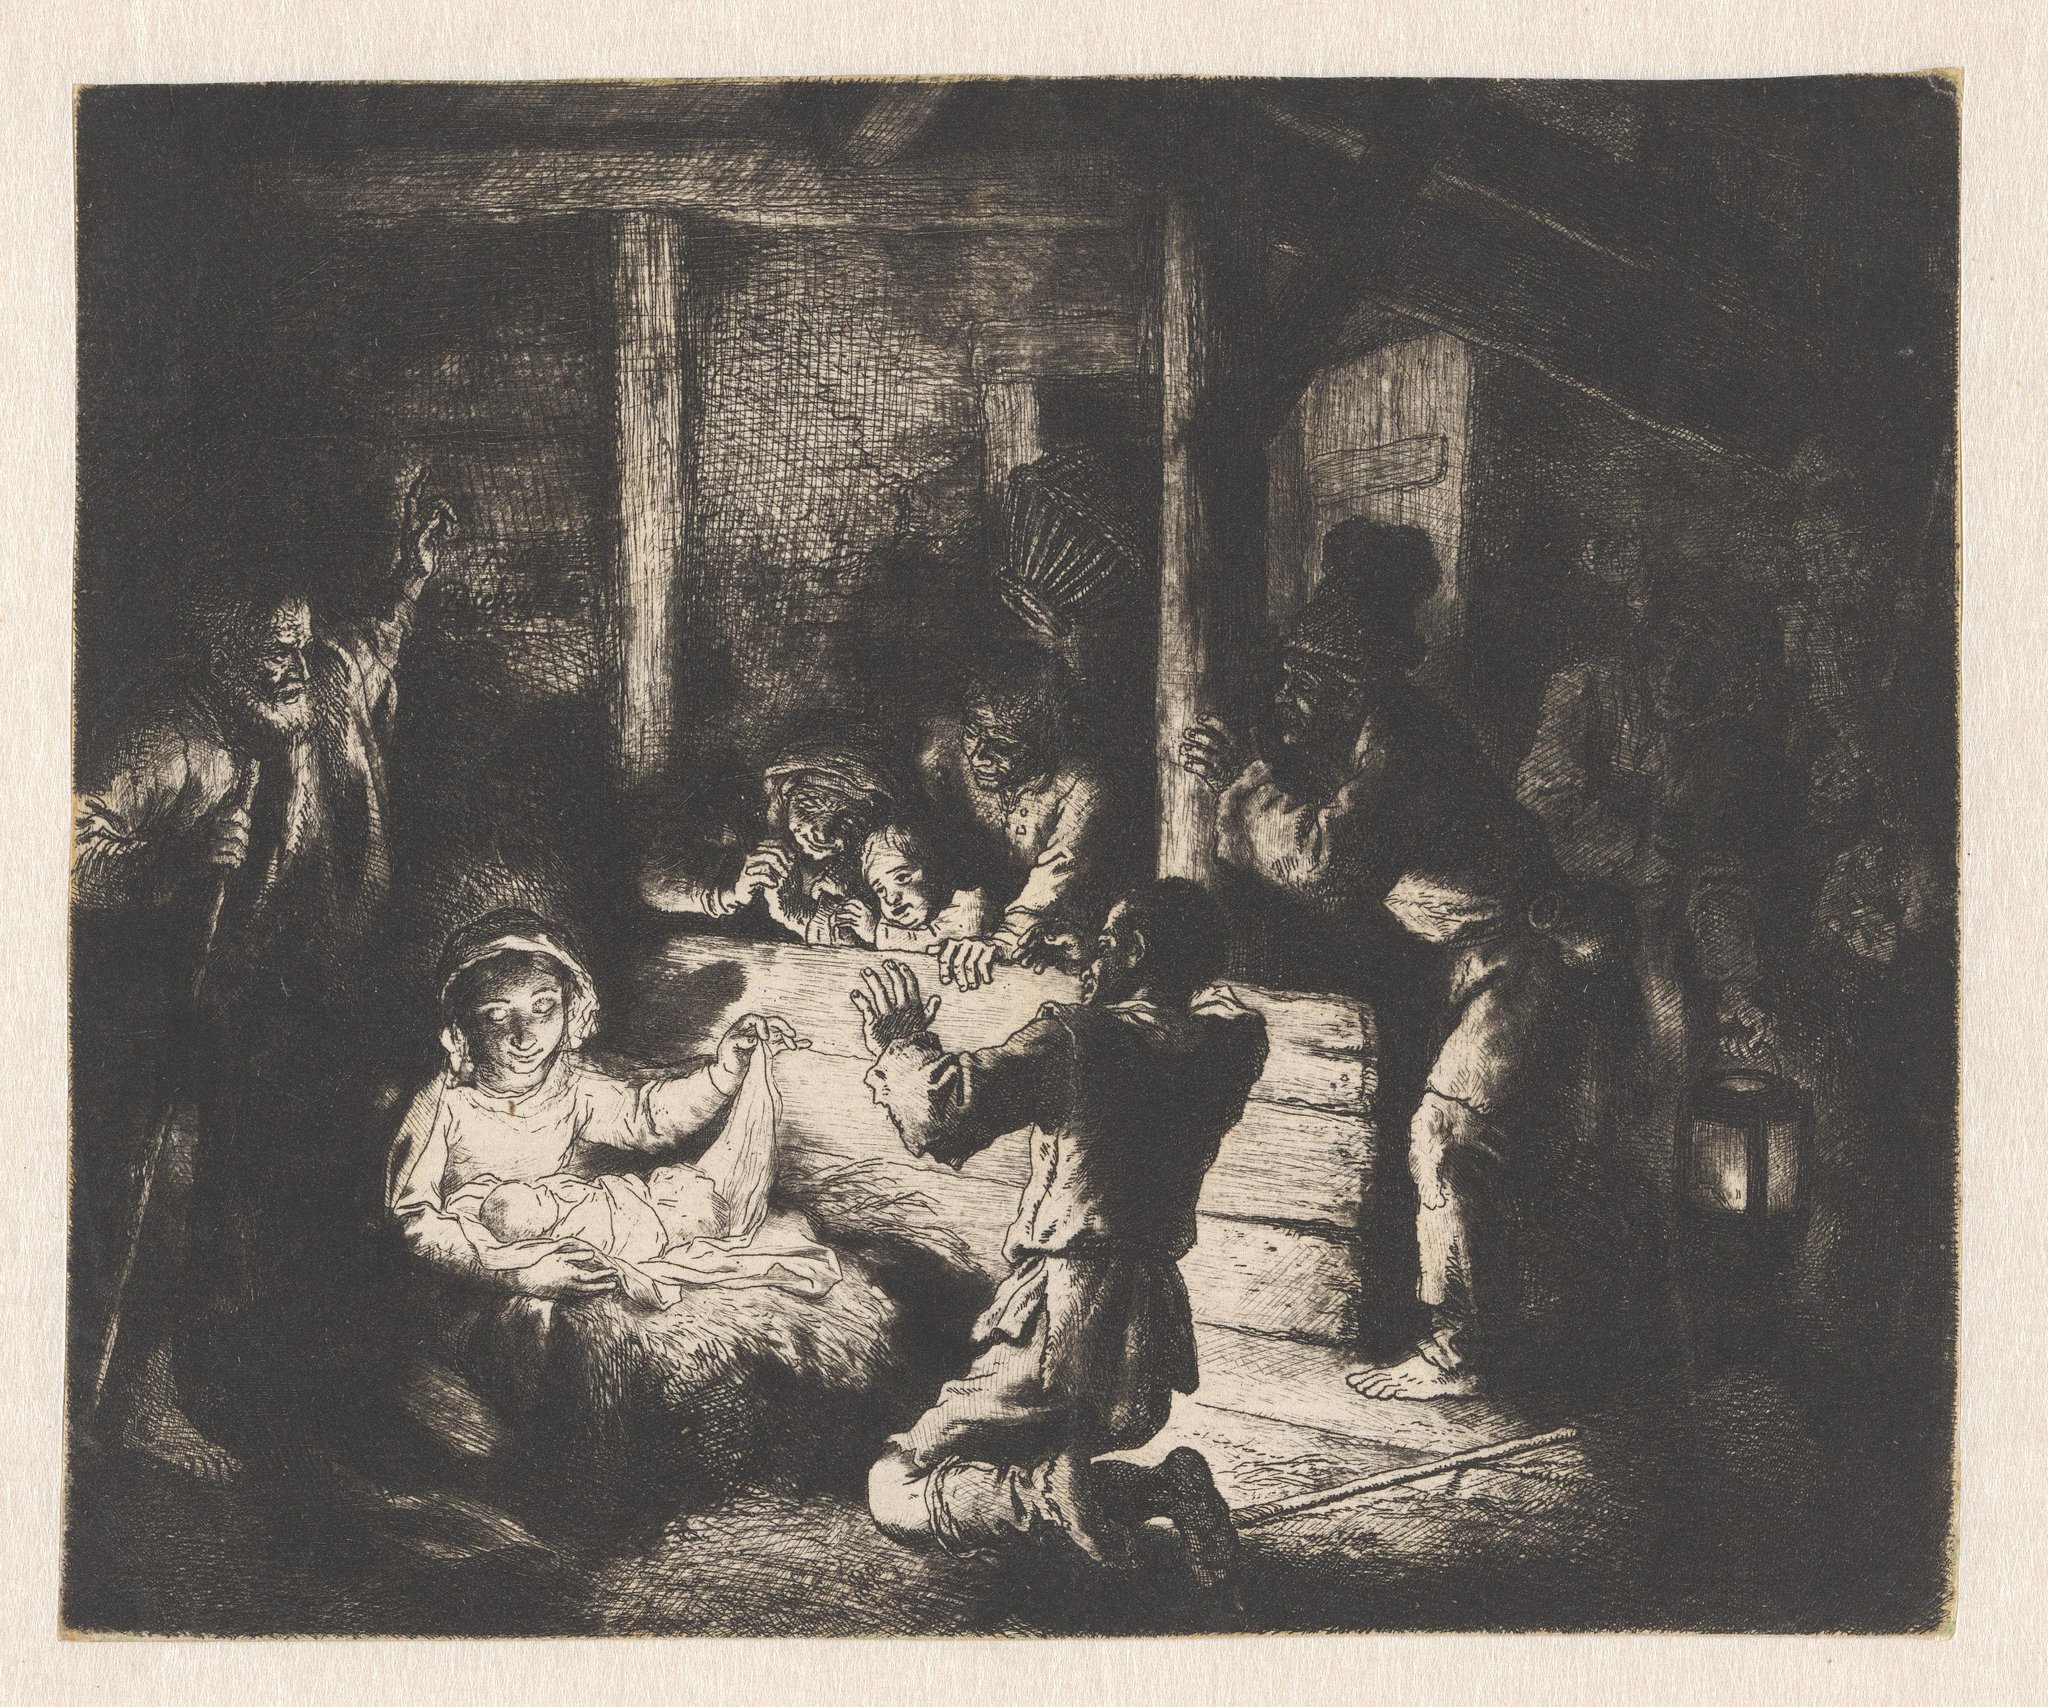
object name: print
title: De geboorte van Christus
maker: christian wilhelm ernst dietrich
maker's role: artist, painter, print maker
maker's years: 1712-1774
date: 1756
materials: paper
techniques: drypoint, etching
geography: dresden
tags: adoration of the christ-child by the shepherds; mary and joseph present, adoration of the christ-child ~ christ's birth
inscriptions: collector's mark: Lugt 2304, collector's mark: Lugt 2760, collector's mark: Lugt 2228, collector's mark: Lugt 1888